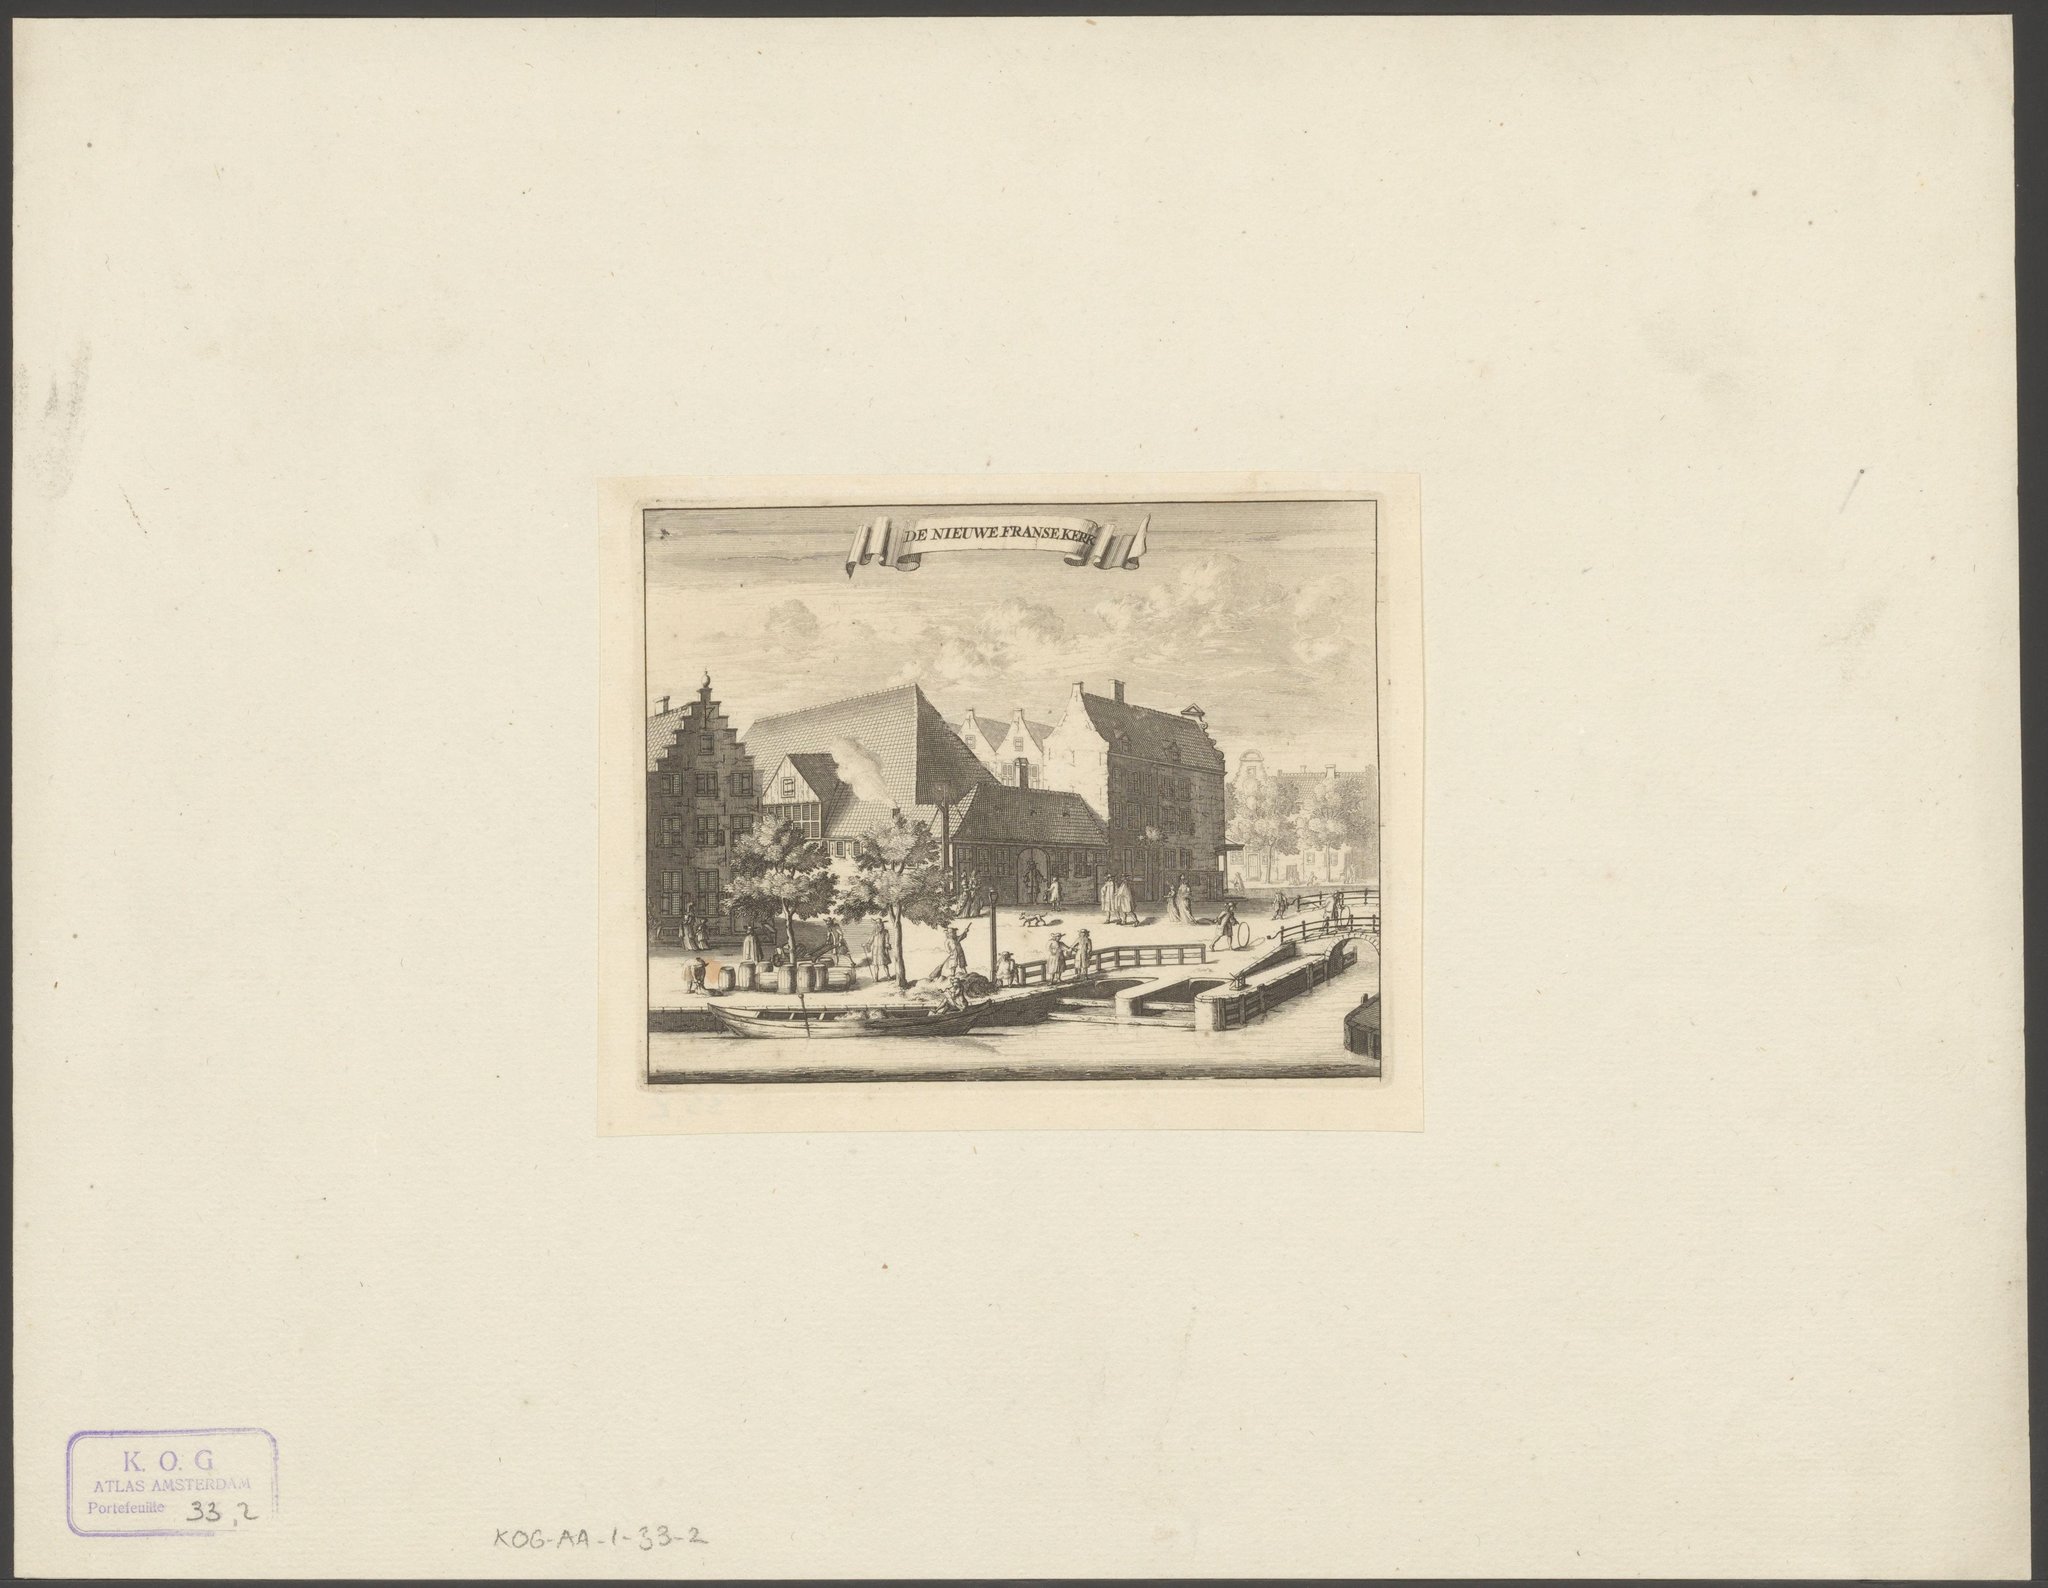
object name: print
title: De Nieuwe Franse Kerk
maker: Anonymous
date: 1693-1694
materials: paper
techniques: engraving, etching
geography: northern netherlands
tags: church (exterior), rowing-boat, canoe, etc., canals, waters (in city) (+ city(-scape) with figures, staffage)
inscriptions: collector's mark: Lugt 1641b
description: Huidige staat van prent ook gebruikt in: Commelin, Casparus. Beschryvinge van Amsterdam (…). Amsterdam: Abraham Wolfgang, Gillis Janssonius van Waesberge of Johannes Janssonius van Waesberge, Hendrick Boom of weduwe Dirk Boom, Abraham van Sanderen en Rembertus Goethals, 1693, dl. 1, p. 482. En in: Commelin, Casparus. Beschryvinge van Amsterdam (…). Amsterdam: weduwe Aart Dircksz. Oossaan, 1694, dl. 1, p. 482. Tweede staat van prent (met opgewerkte lucht en water) ook gebruikt in: Commelin, Casparus. Beschryvinge van Amsterdam (…). 2de druk. Amsterdam: Andries van Damme, Johannes Ratelband, weduwe Antony van Aeltwijk en Hermanus Uytwerf, 1726, dl. 1, p. 482.